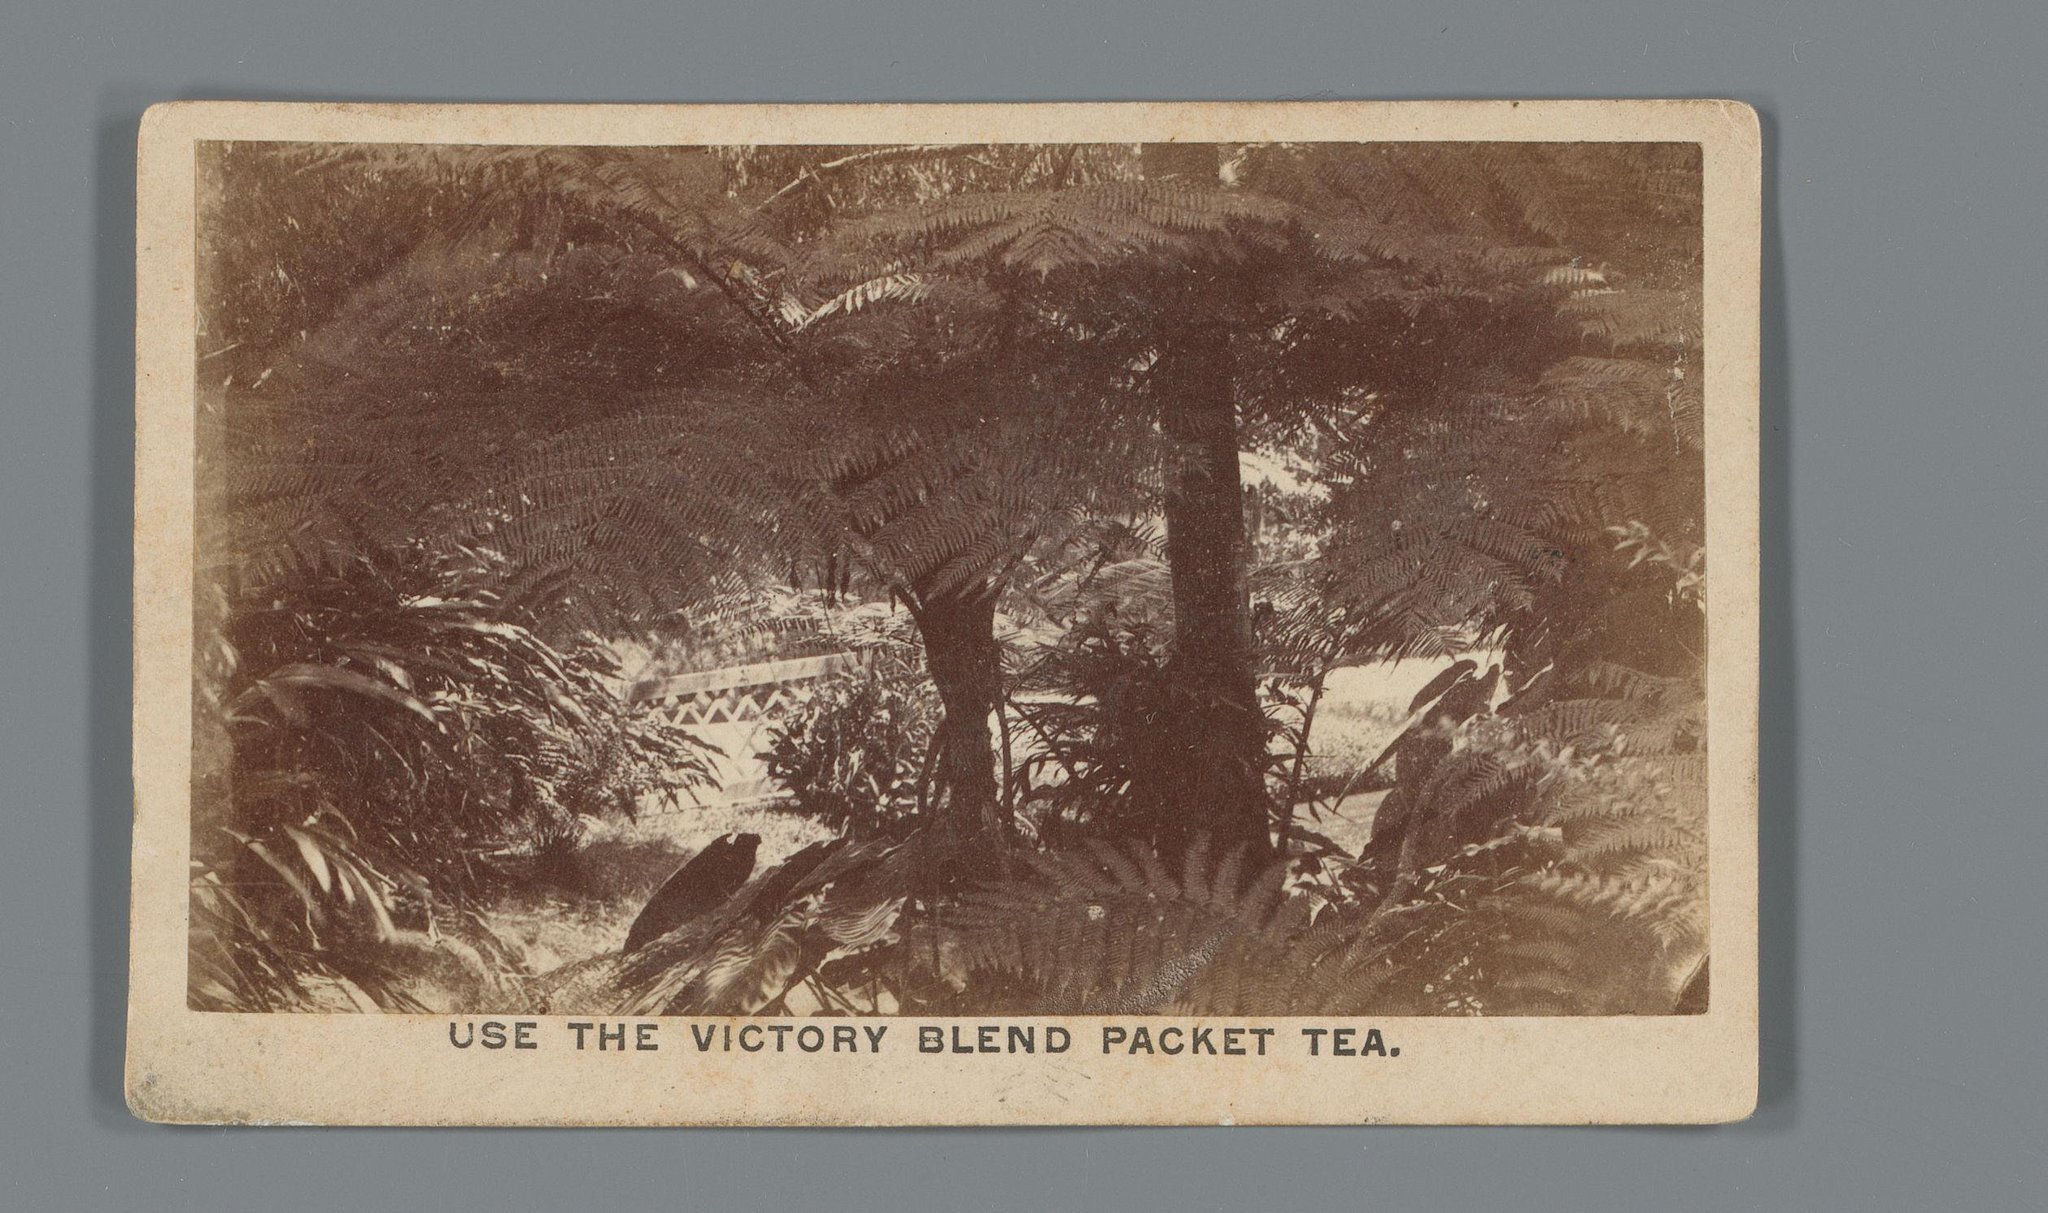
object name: photograph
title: Gezicht op een botanische tuin met varens in Sydney als reclame voor thee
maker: Anonymous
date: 1850-1915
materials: cardboard, photographic support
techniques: albumen print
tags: advertising, ferns, tea (leaves), botanic garden, 'hortus botanicus'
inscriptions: inscription: ‘USE THE VICTORY BLEND TEA.’, inscription: ‘View in the Botanical Gardens,/ SYDNEY.’